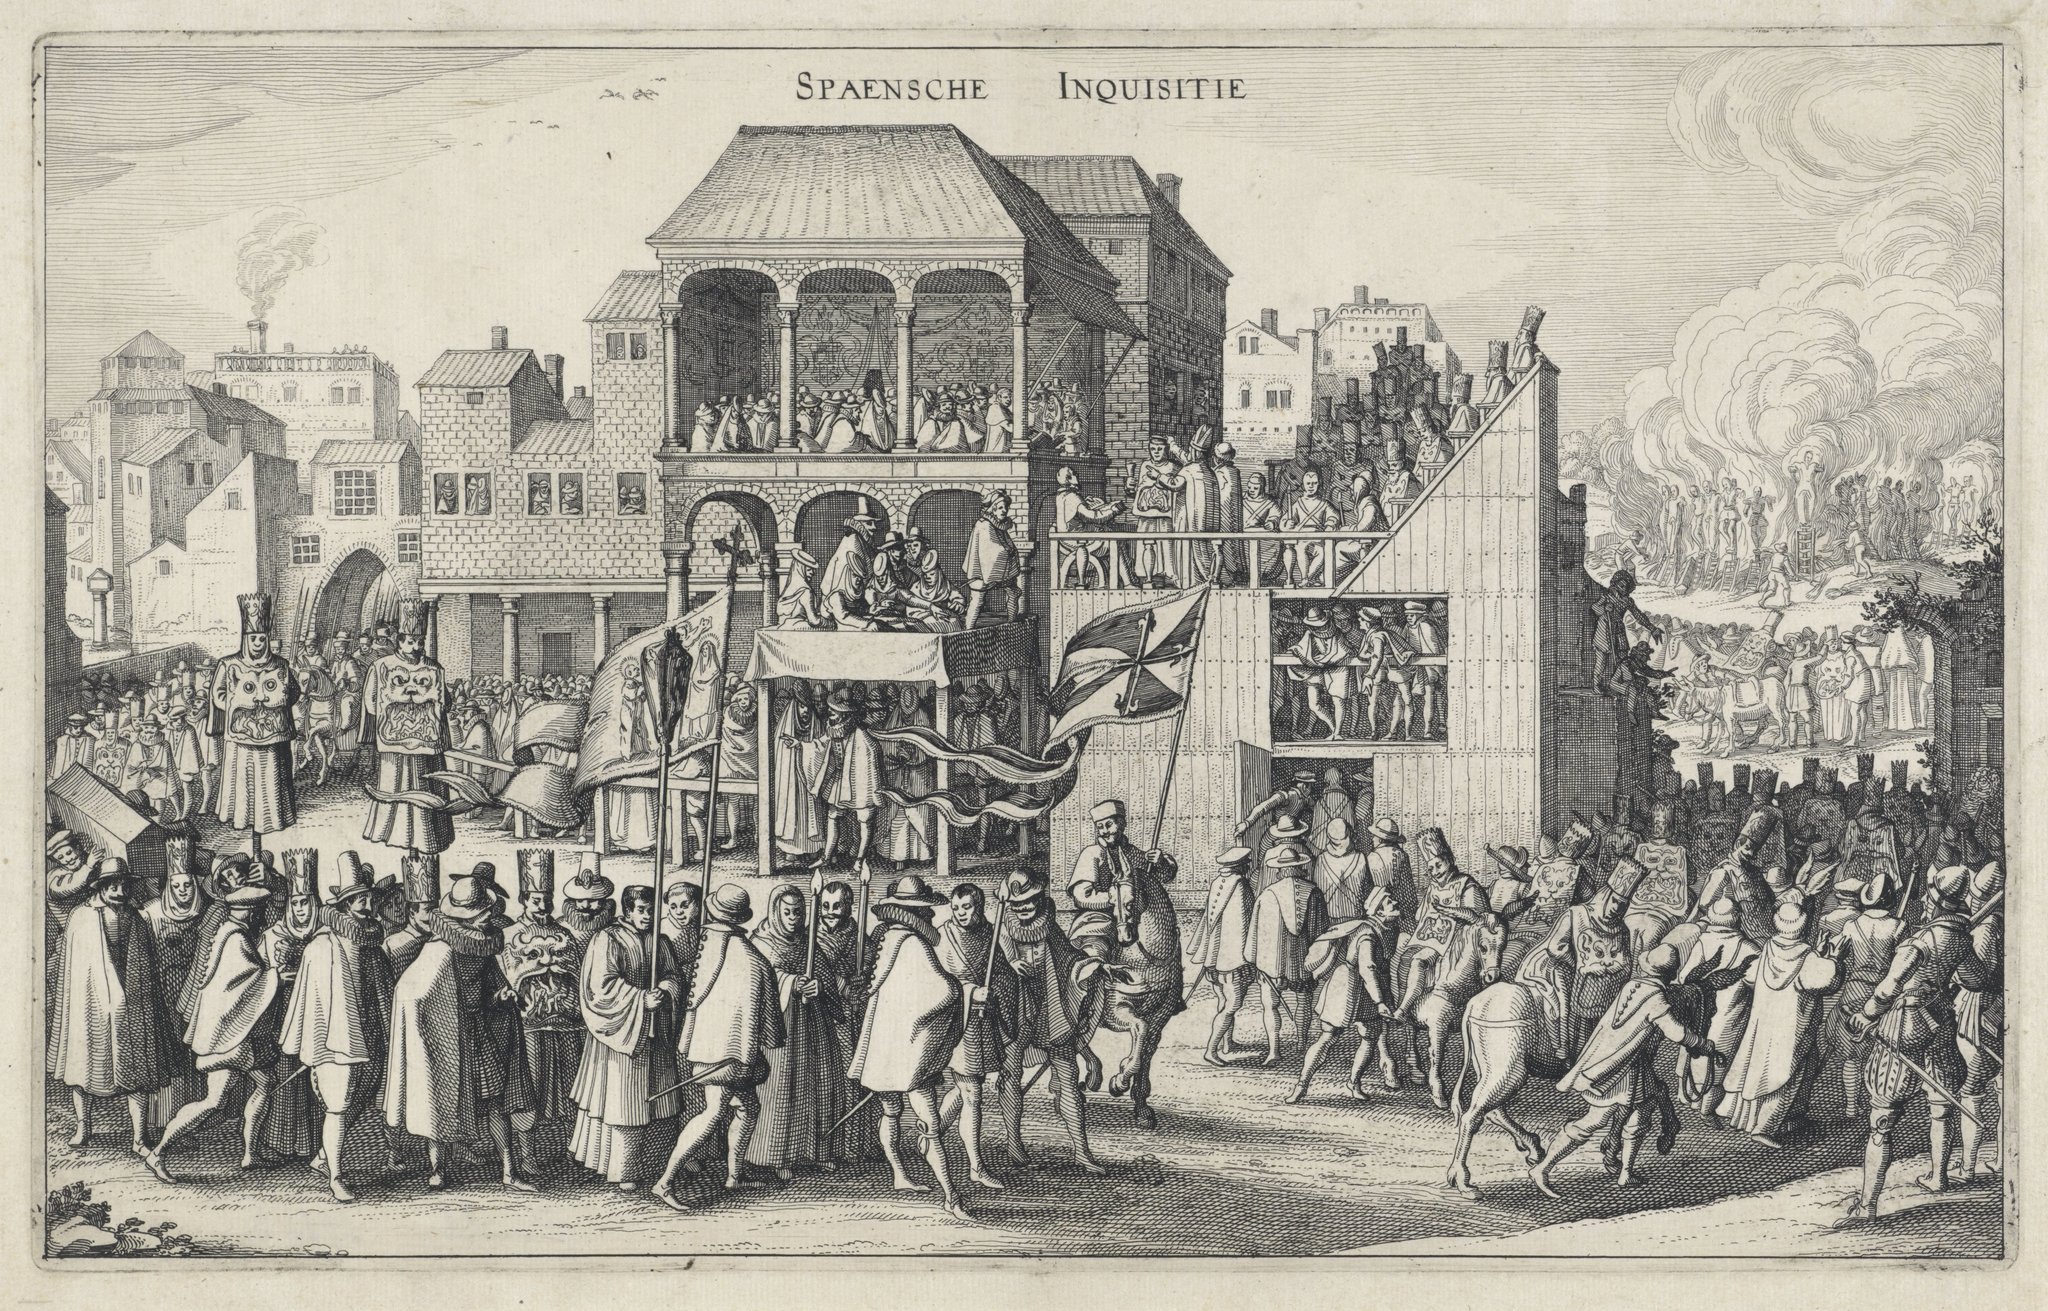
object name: print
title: Spaensche Inquisitie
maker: claes jansz. visscher (ii)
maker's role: draughtsman, print maker, publisher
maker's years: 1586-1652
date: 1596-1652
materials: paper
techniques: etching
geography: amsterdam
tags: violent death, being killed; being mishandled and maltreated; seeking death (+ death by inquisition), execution of heretic, e.g. by burning at the stake, 'auto-da-fé', inquisition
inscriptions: title: ‘SPAENSCHE INQUISITIE’, collector's mark: Lugt 240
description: Auto-da-fe (autodafe) in Valladolid, 21 mei 1558. Processie van circa dertig door de Spaanse Inquisitie ter dood veroordeelde protestanten naar een plaats buiten de stad waar ze op de brandstapel verbrand worden. In het midden een gebouw met hoogwaardigheidsbekleders, hiernaast een houten tribune waarop de ketters veroordeeld worden. De veroordeelden dragen een speciale hoofddeksel (capirote) en mantel met een voorstelling van de hellemond. Verkleinde kopie naar de oorspronkelijke eigentijdse voorstelling op vier bladen.